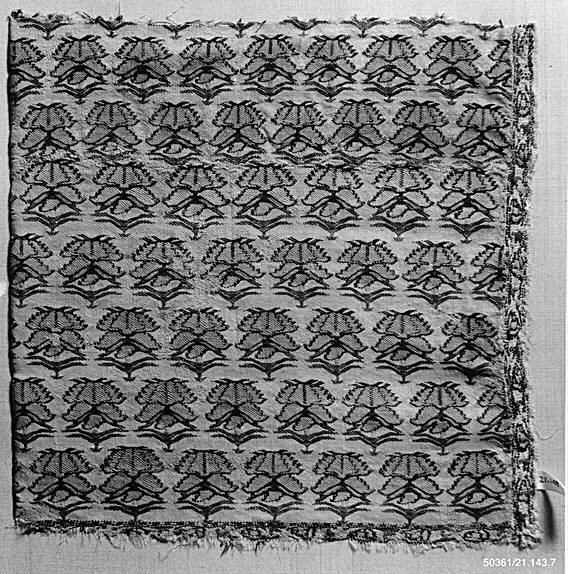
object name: textile fragment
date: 1701-1800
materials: wool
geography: india